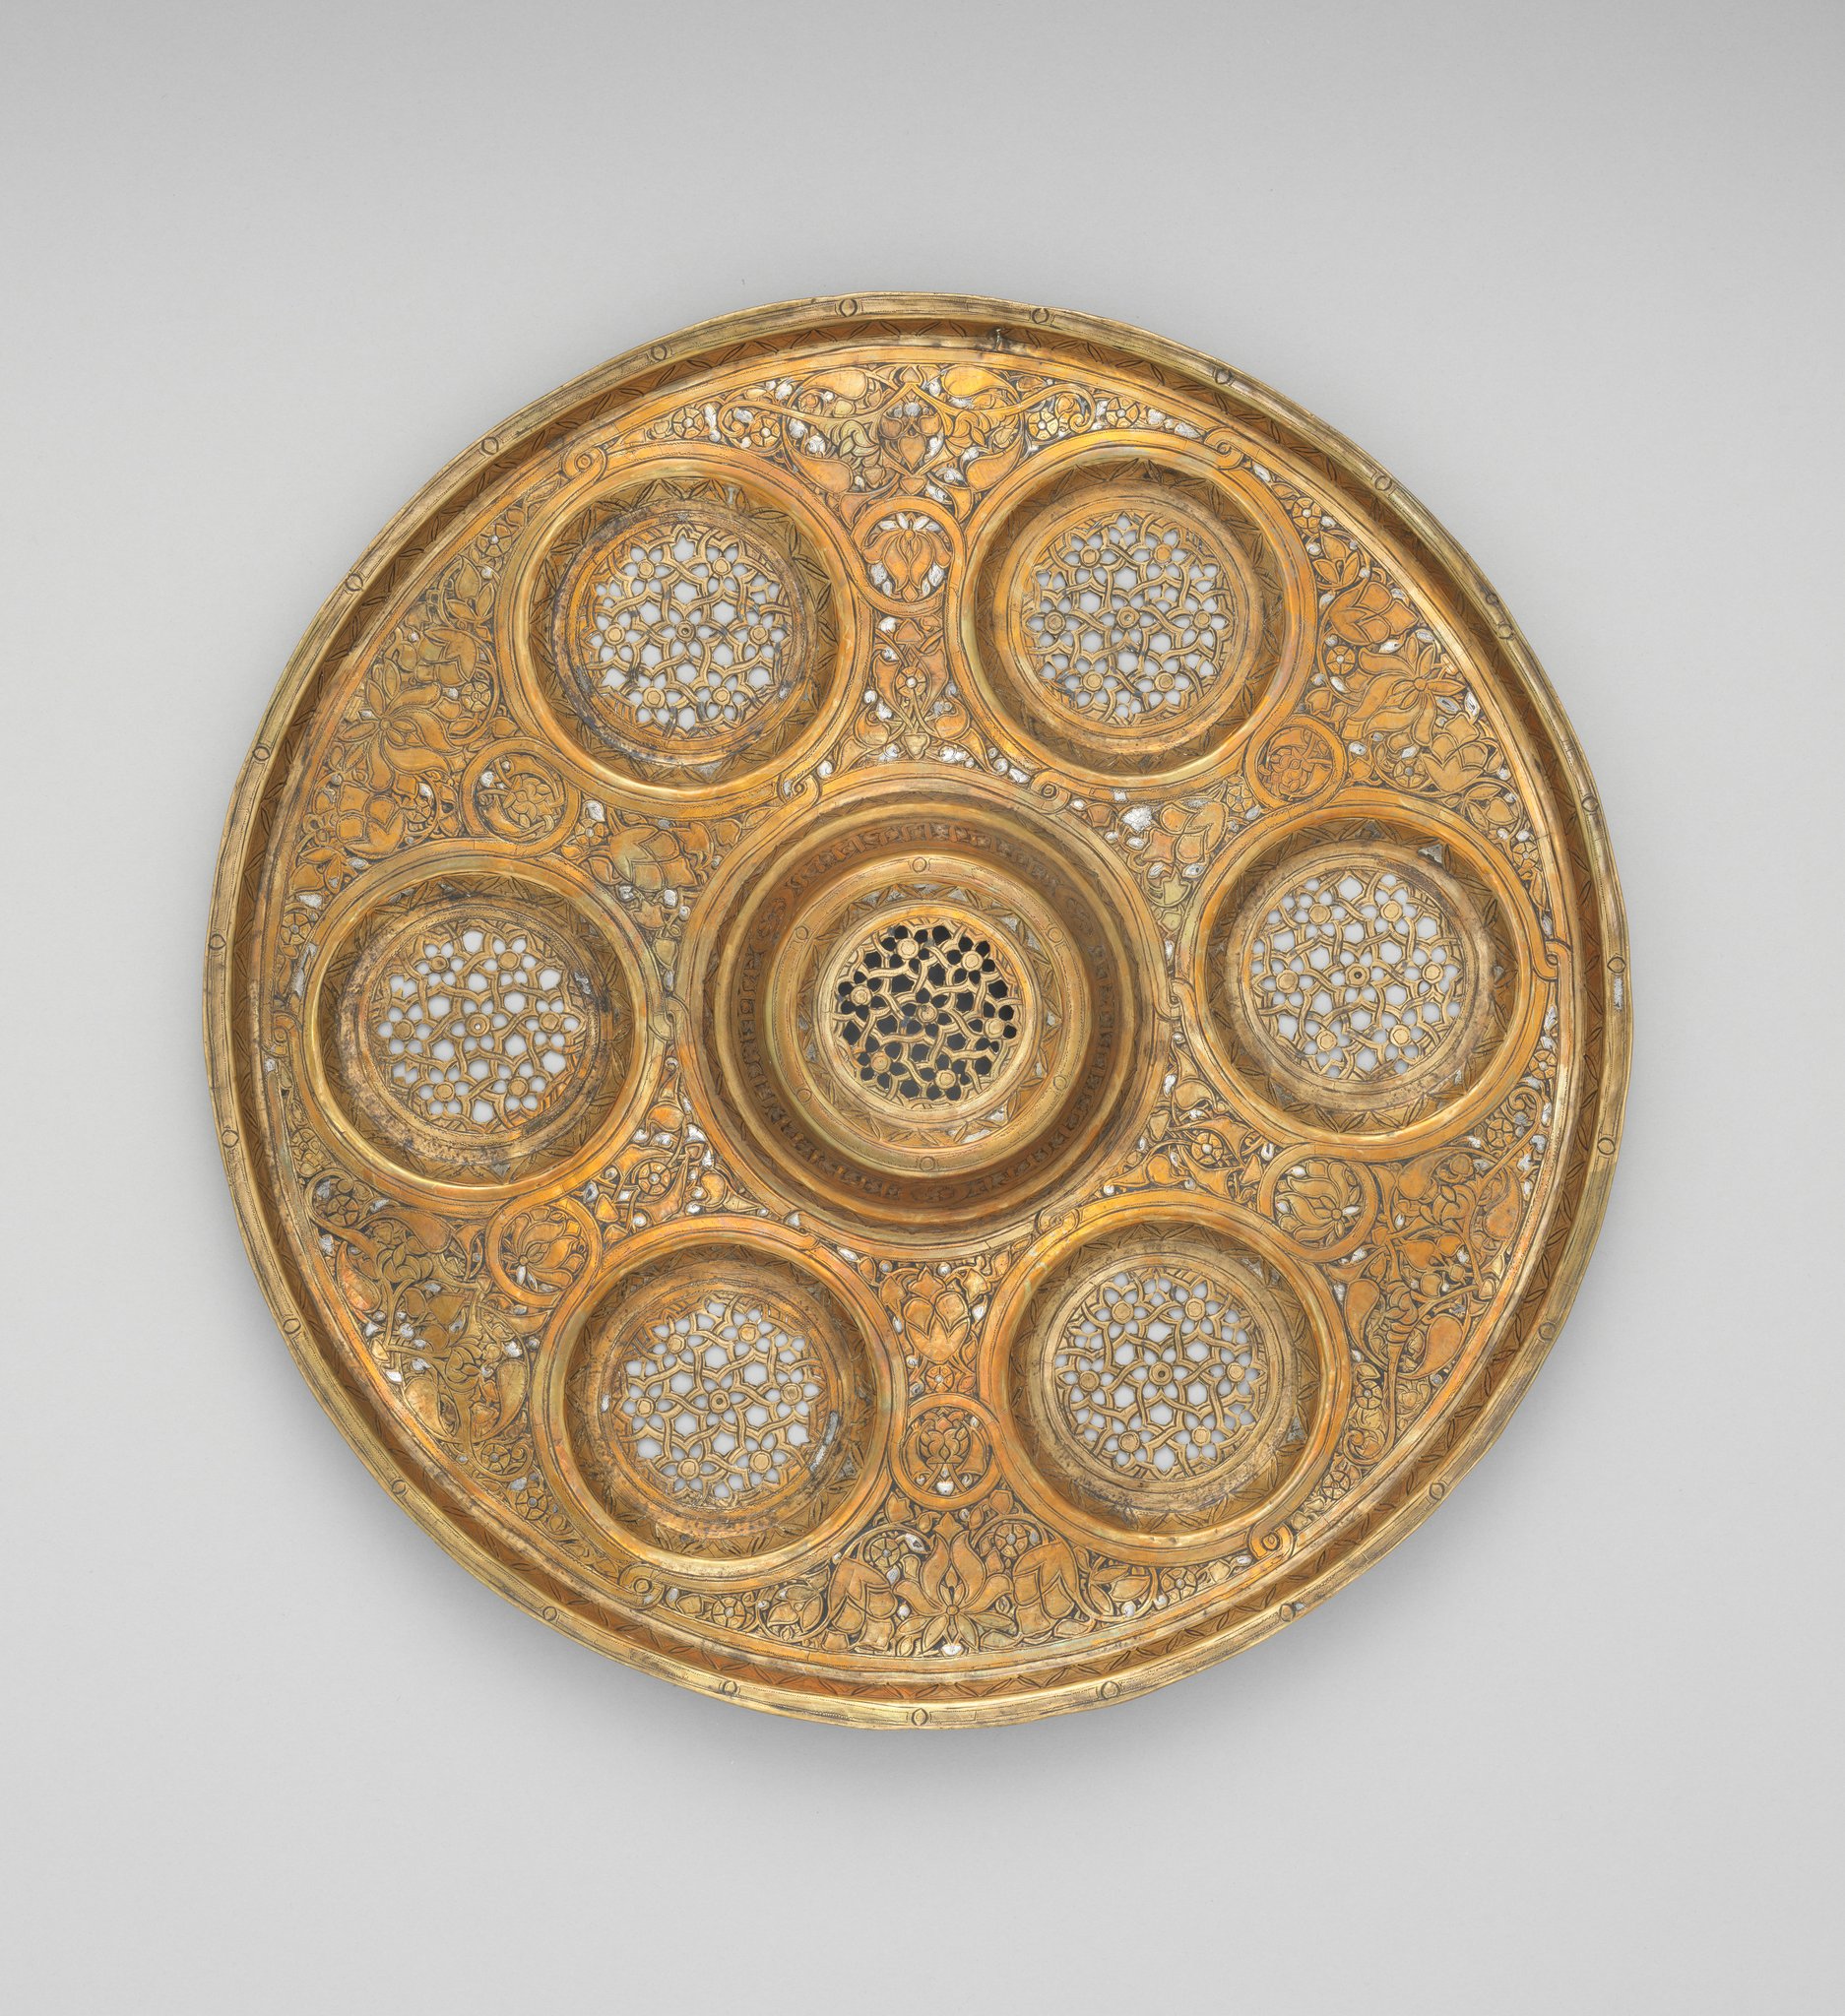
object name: tray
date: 1301-1350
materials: brass, silver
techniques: inlay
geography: egypt